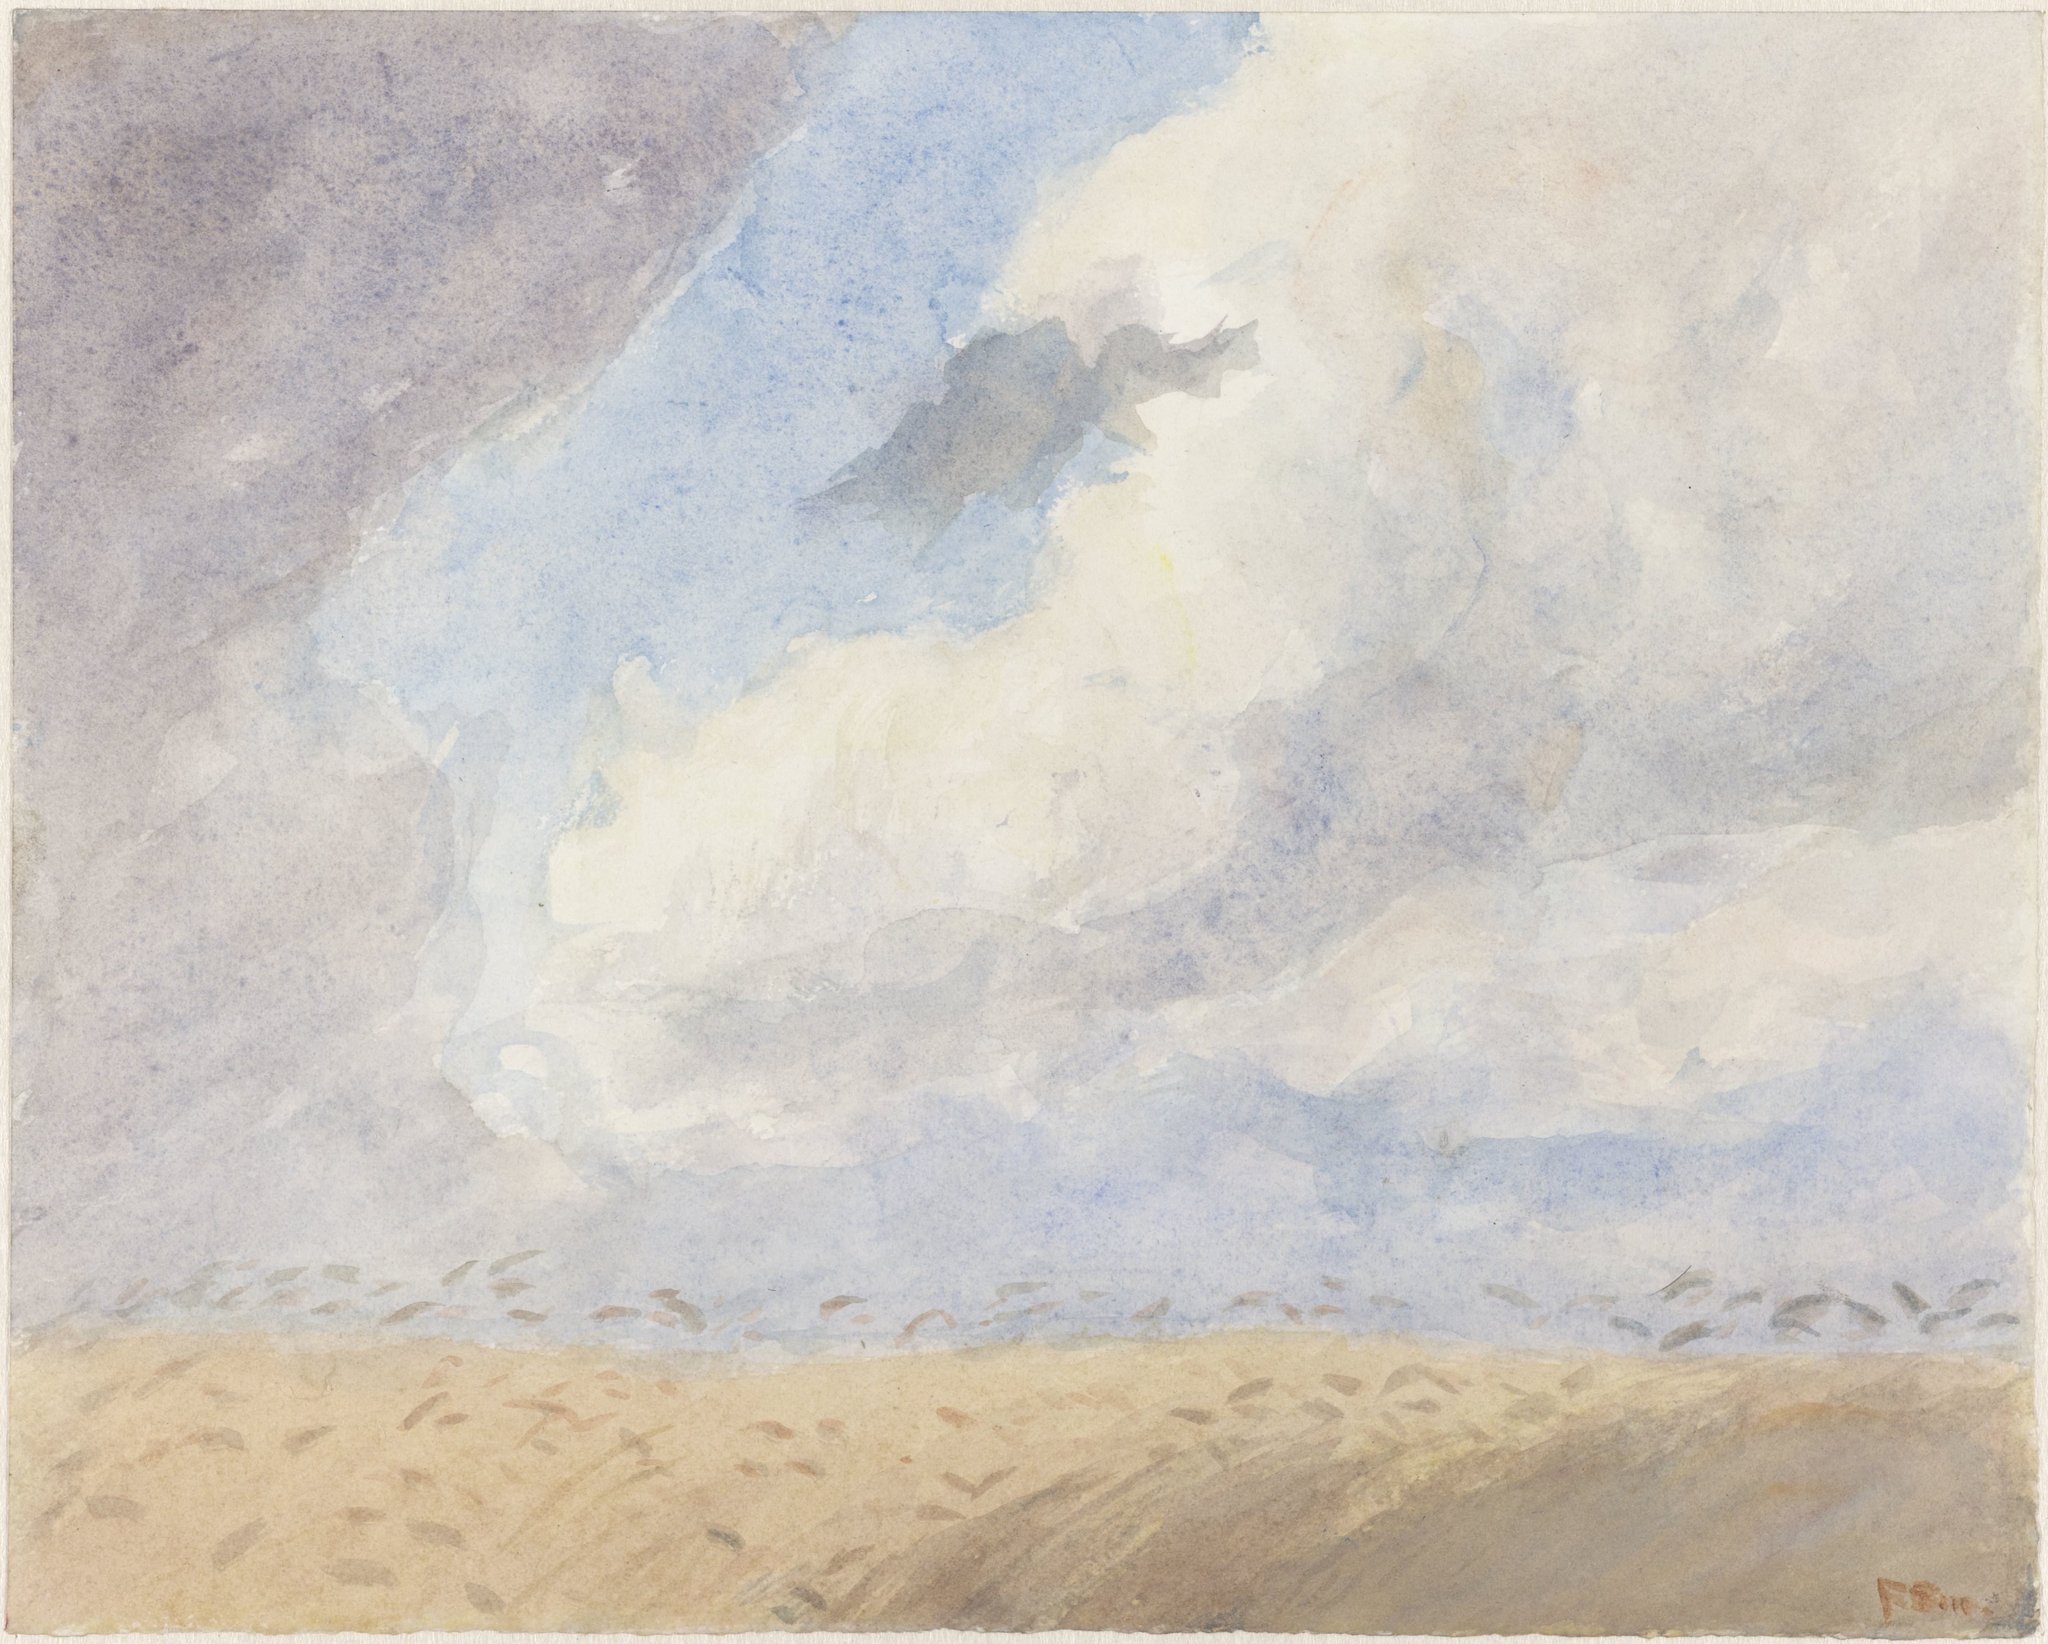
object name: watercolor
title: Korenveld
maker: frans smissaert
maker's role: draughtsman, print maker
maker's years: 1862-1944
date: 1872-1944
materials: paper, watercolor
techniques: brush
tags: cultivated land, cereal, grain, corn (grass with grains, grown for food, e.g.: wheat, rice, rye, oats, maize, buckwheat, millet)